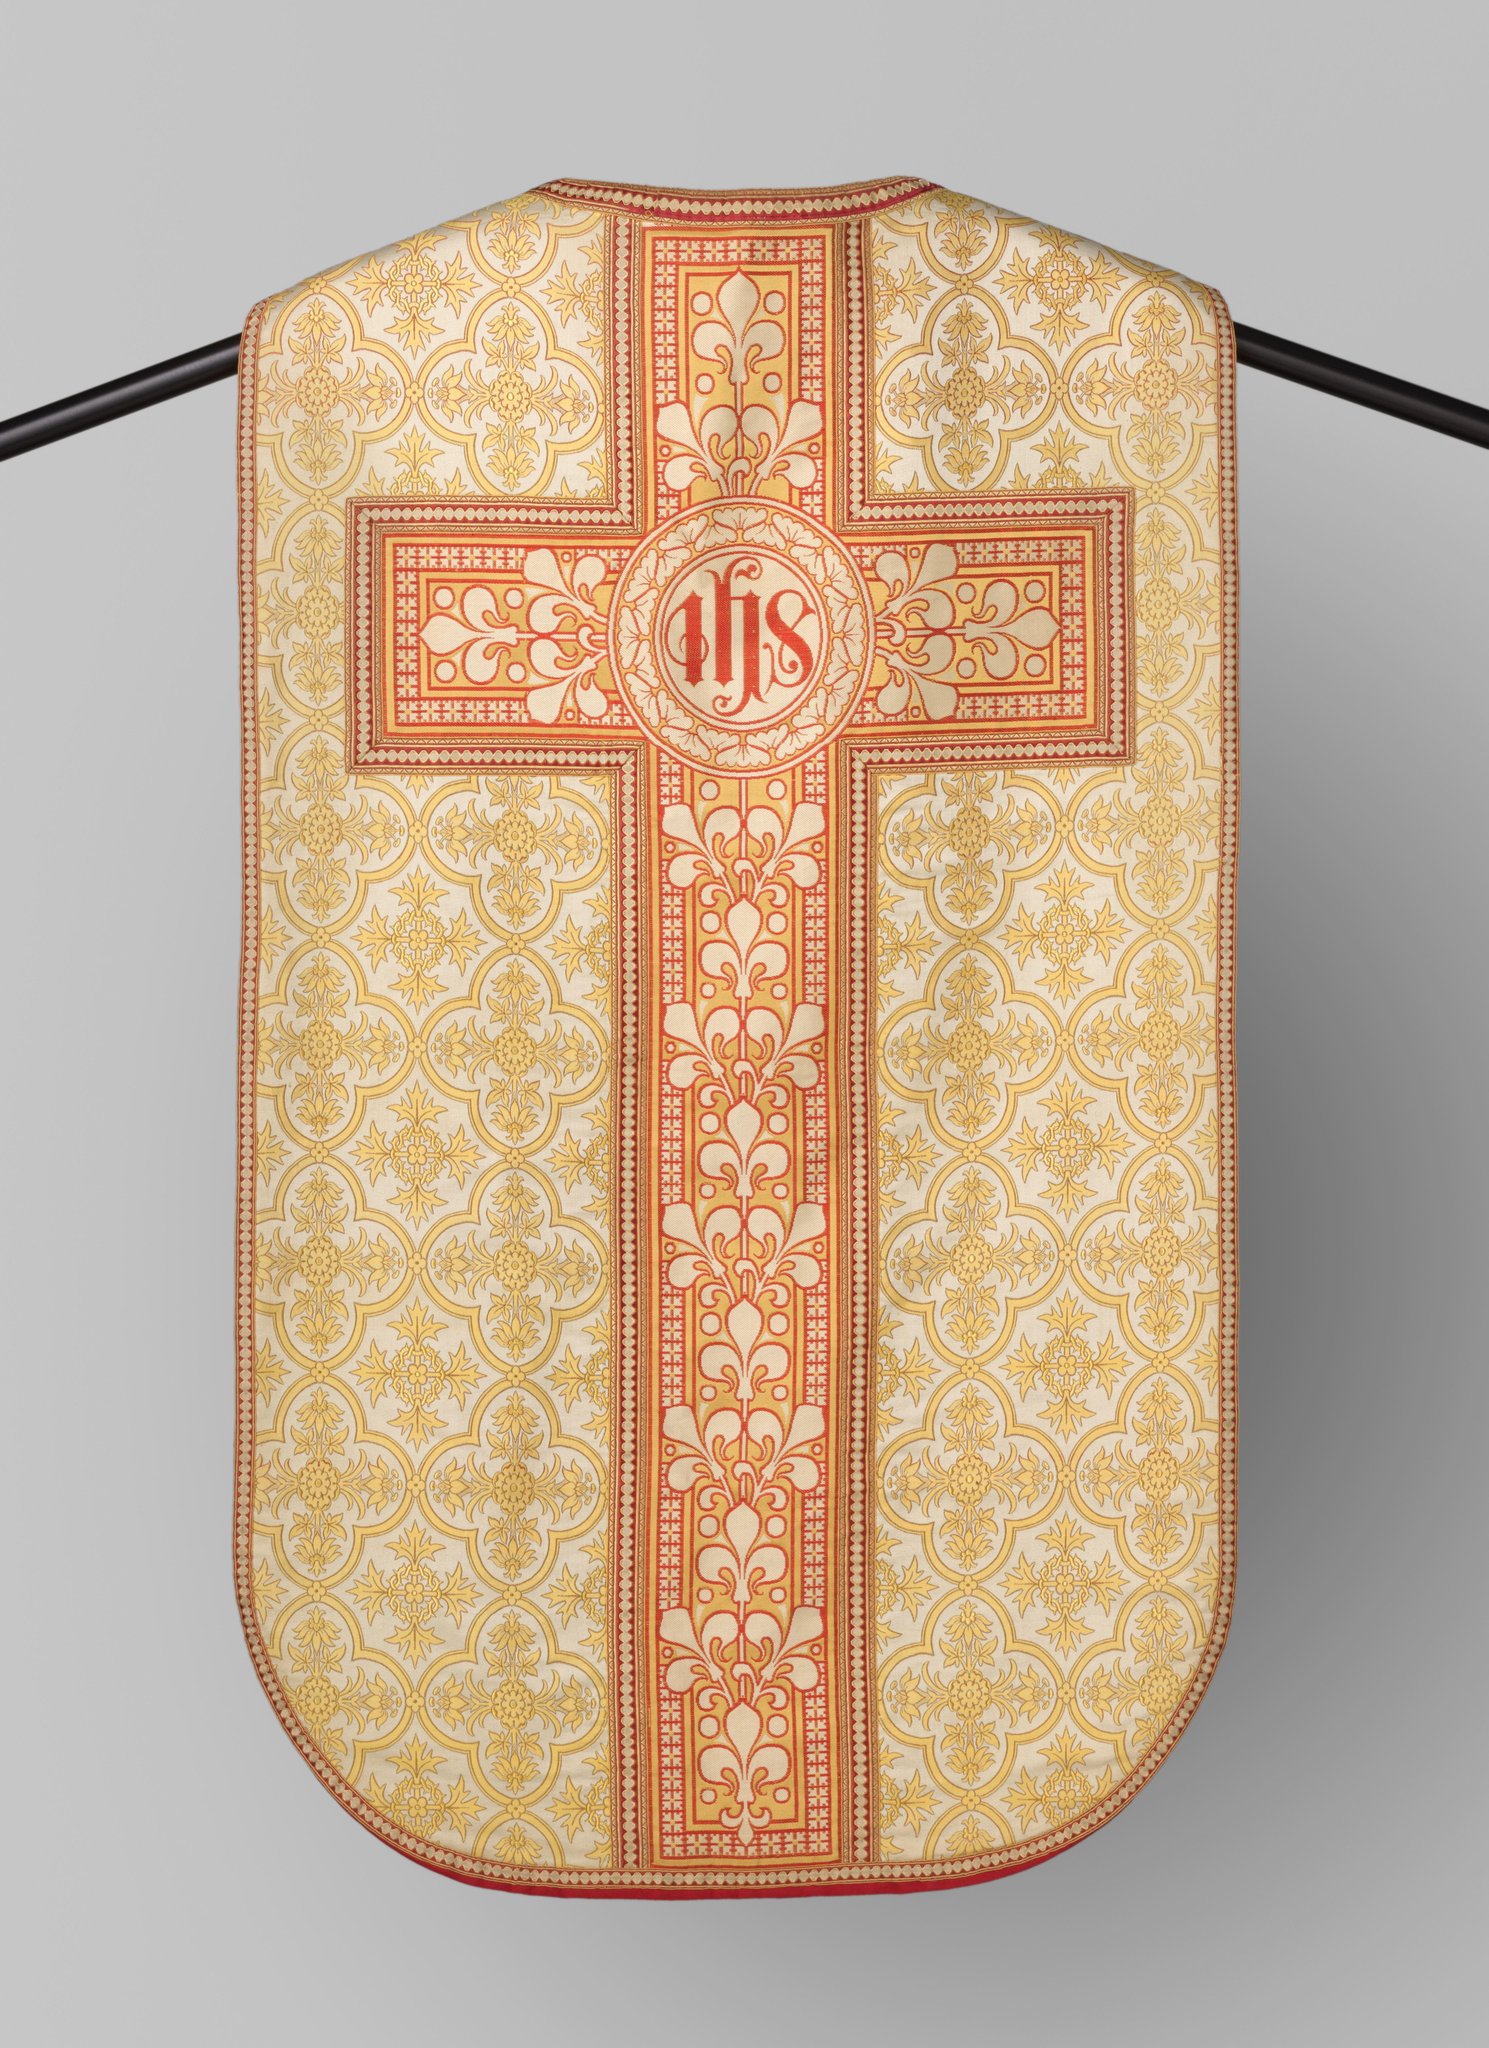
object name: chasuble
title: Kazuifel versierd met aaneengeschakelde vierpassen waarbinnen gestileerde passiebloemen, distelbladeren en een doornenkroon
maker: Anonymous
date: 1850-1900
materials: cotton, silk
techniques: embroidered, weave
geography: germany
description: Kazuifel van zijde met het Christusmonogram IHS. Zijdeweefsel Duitsland (?), gemaakt in Nederland, 2de helft 19de eeuw.